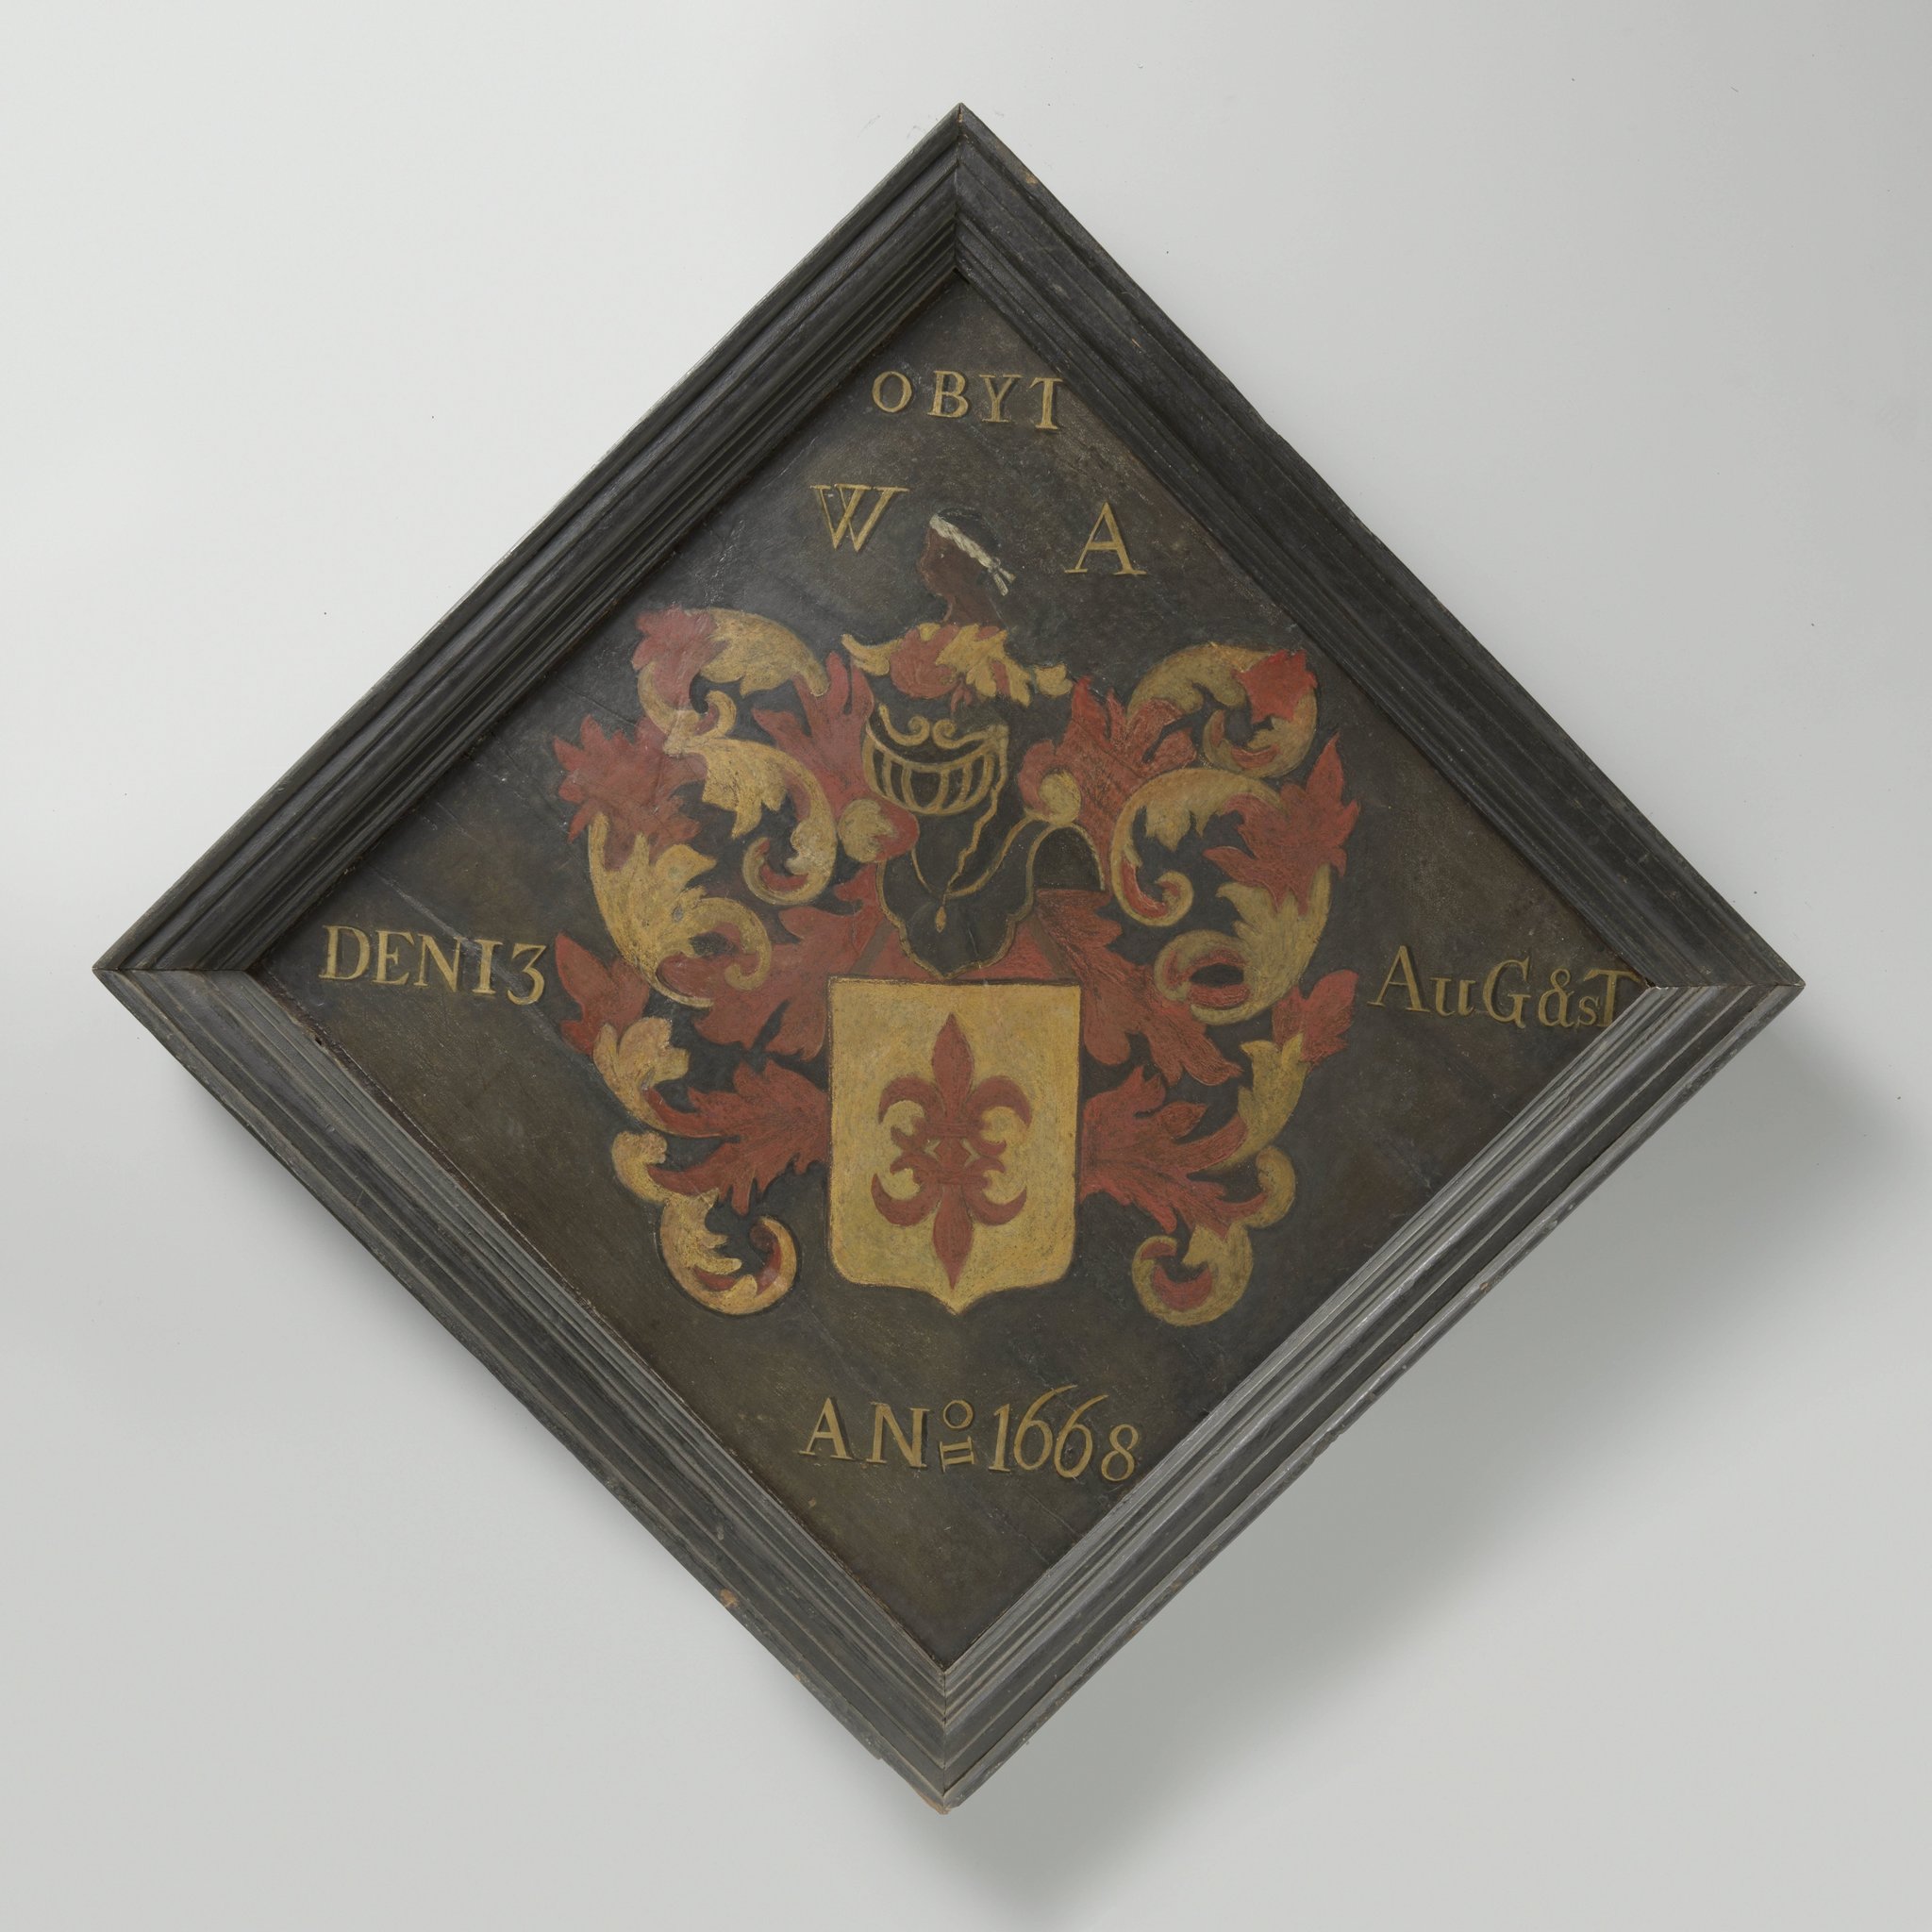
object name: rouwbord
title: Grafbord van Arnoldus van Wachtendonck (gestorven 1668), plaatsvervangend directeur van Bengalen (1665-68)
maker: Anonymous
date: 1668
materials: oil, wood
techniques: woodworking, painted, sawing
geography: bengal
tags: armorial bearing, heraldry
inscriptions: inscription: ‘Obyt W.A. Den 13 AuGusT Ano 1668’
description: Zwart geschilderd ruitvormig grafbord van Arnoldus van Wachtendonck, plaatsvervangend directeur van Bengalen (1665-1668). Gemaakt van Indiaas hout met geprofileerde houten lijst. In het midden gehelmd wapen: een heraldische lelie op een geel veld. Helmkleden en hoofd van een zwarte man als helmteken. Daaromheen opschrift in gele letters: 'Obyt W.A. Den 13 AuGusT Ano 1668'.